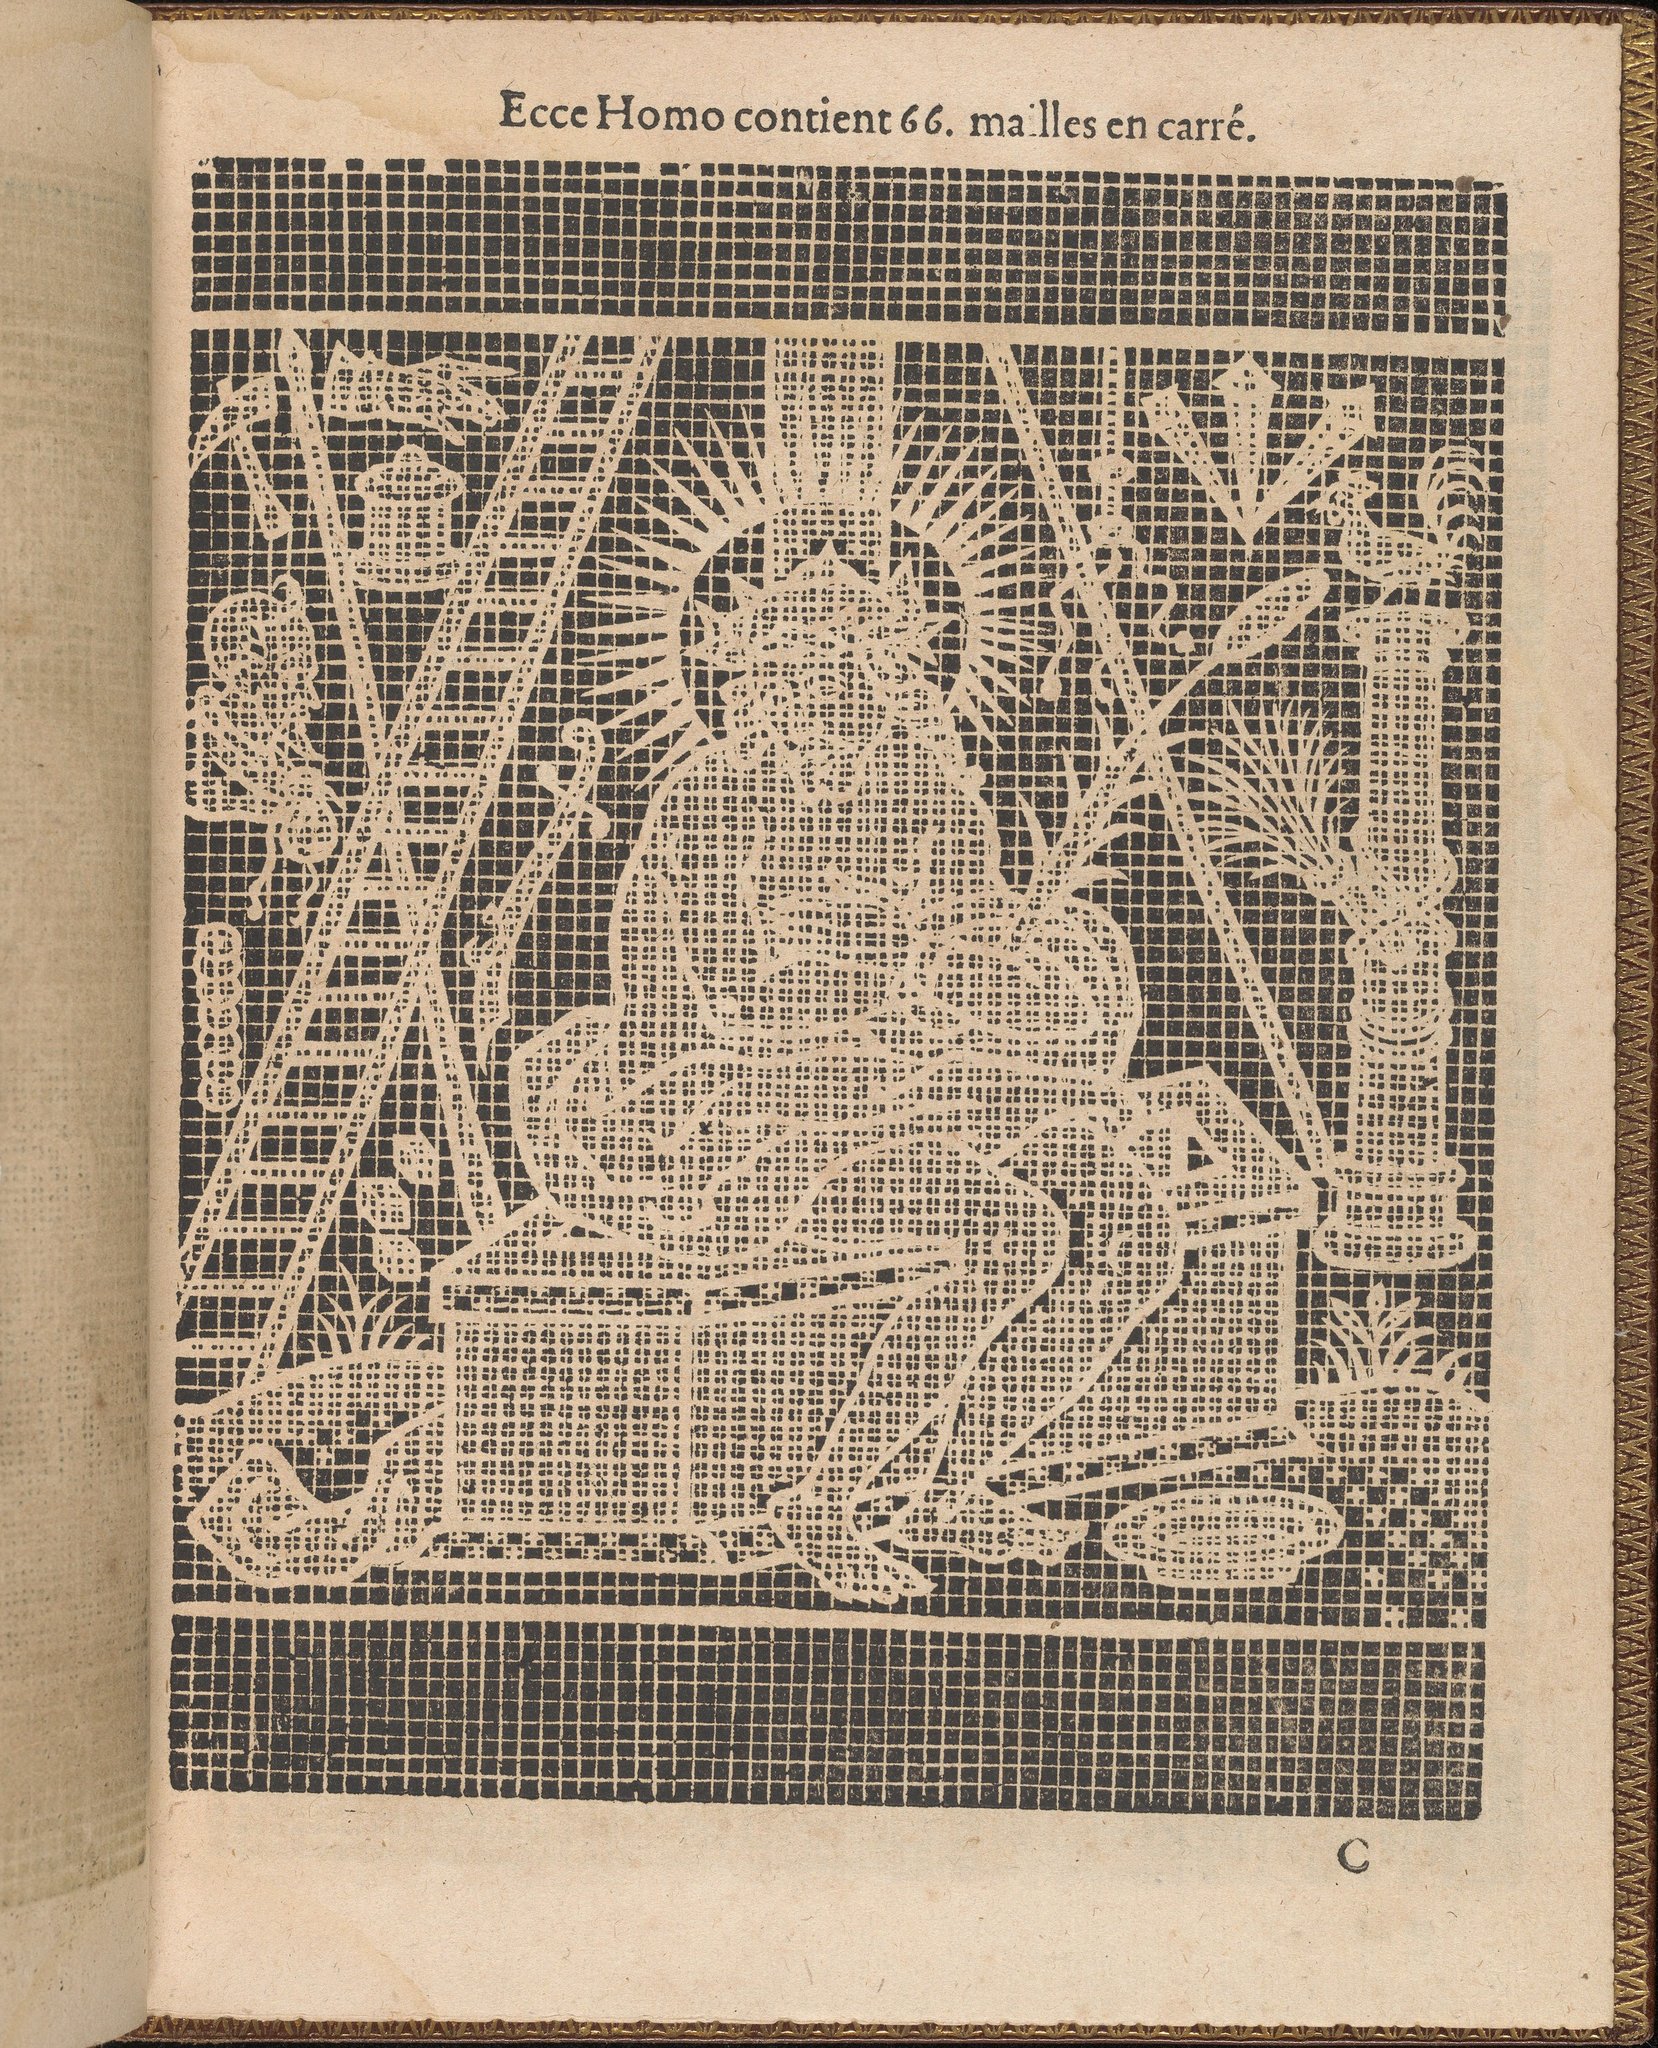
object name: book print ornament architecture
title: La Pratique de l'Aiguille, page 9 (recto)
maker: matthias mignerak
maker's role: author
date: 1605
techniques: woodcut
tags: jesus